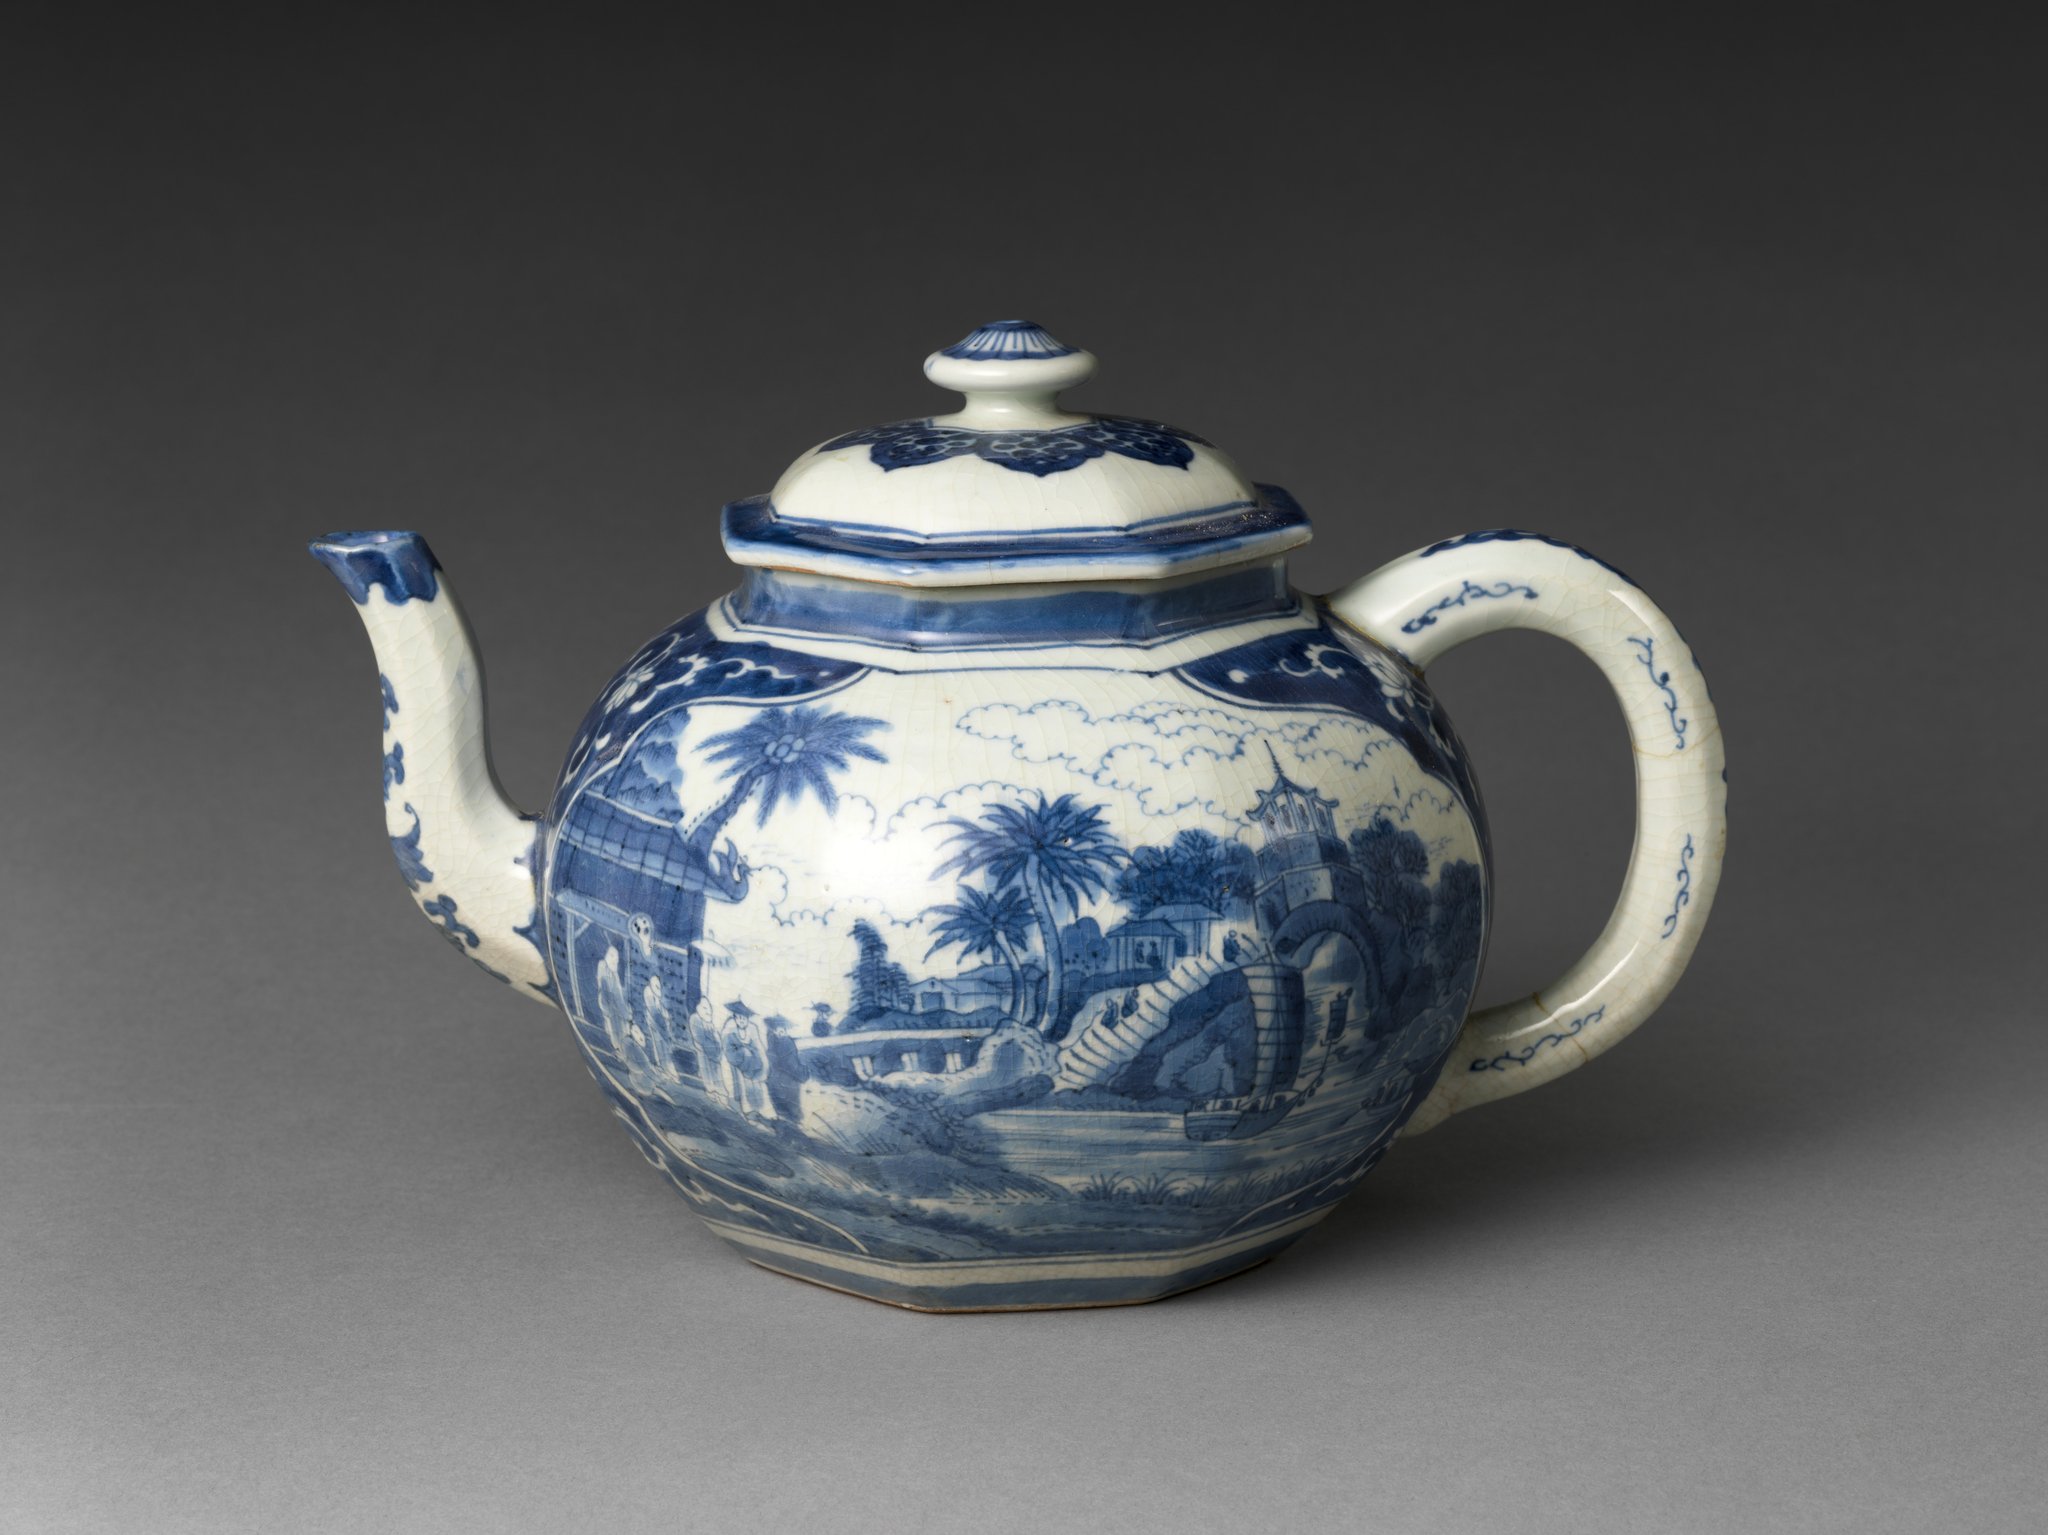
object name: teapot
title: Teapot with Landscape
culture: japanese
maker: olfert dapper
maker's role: artist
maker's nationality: dutch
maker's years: 1639-1689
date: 1701-1733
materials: cobalt, glaze, porcelain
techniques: painting